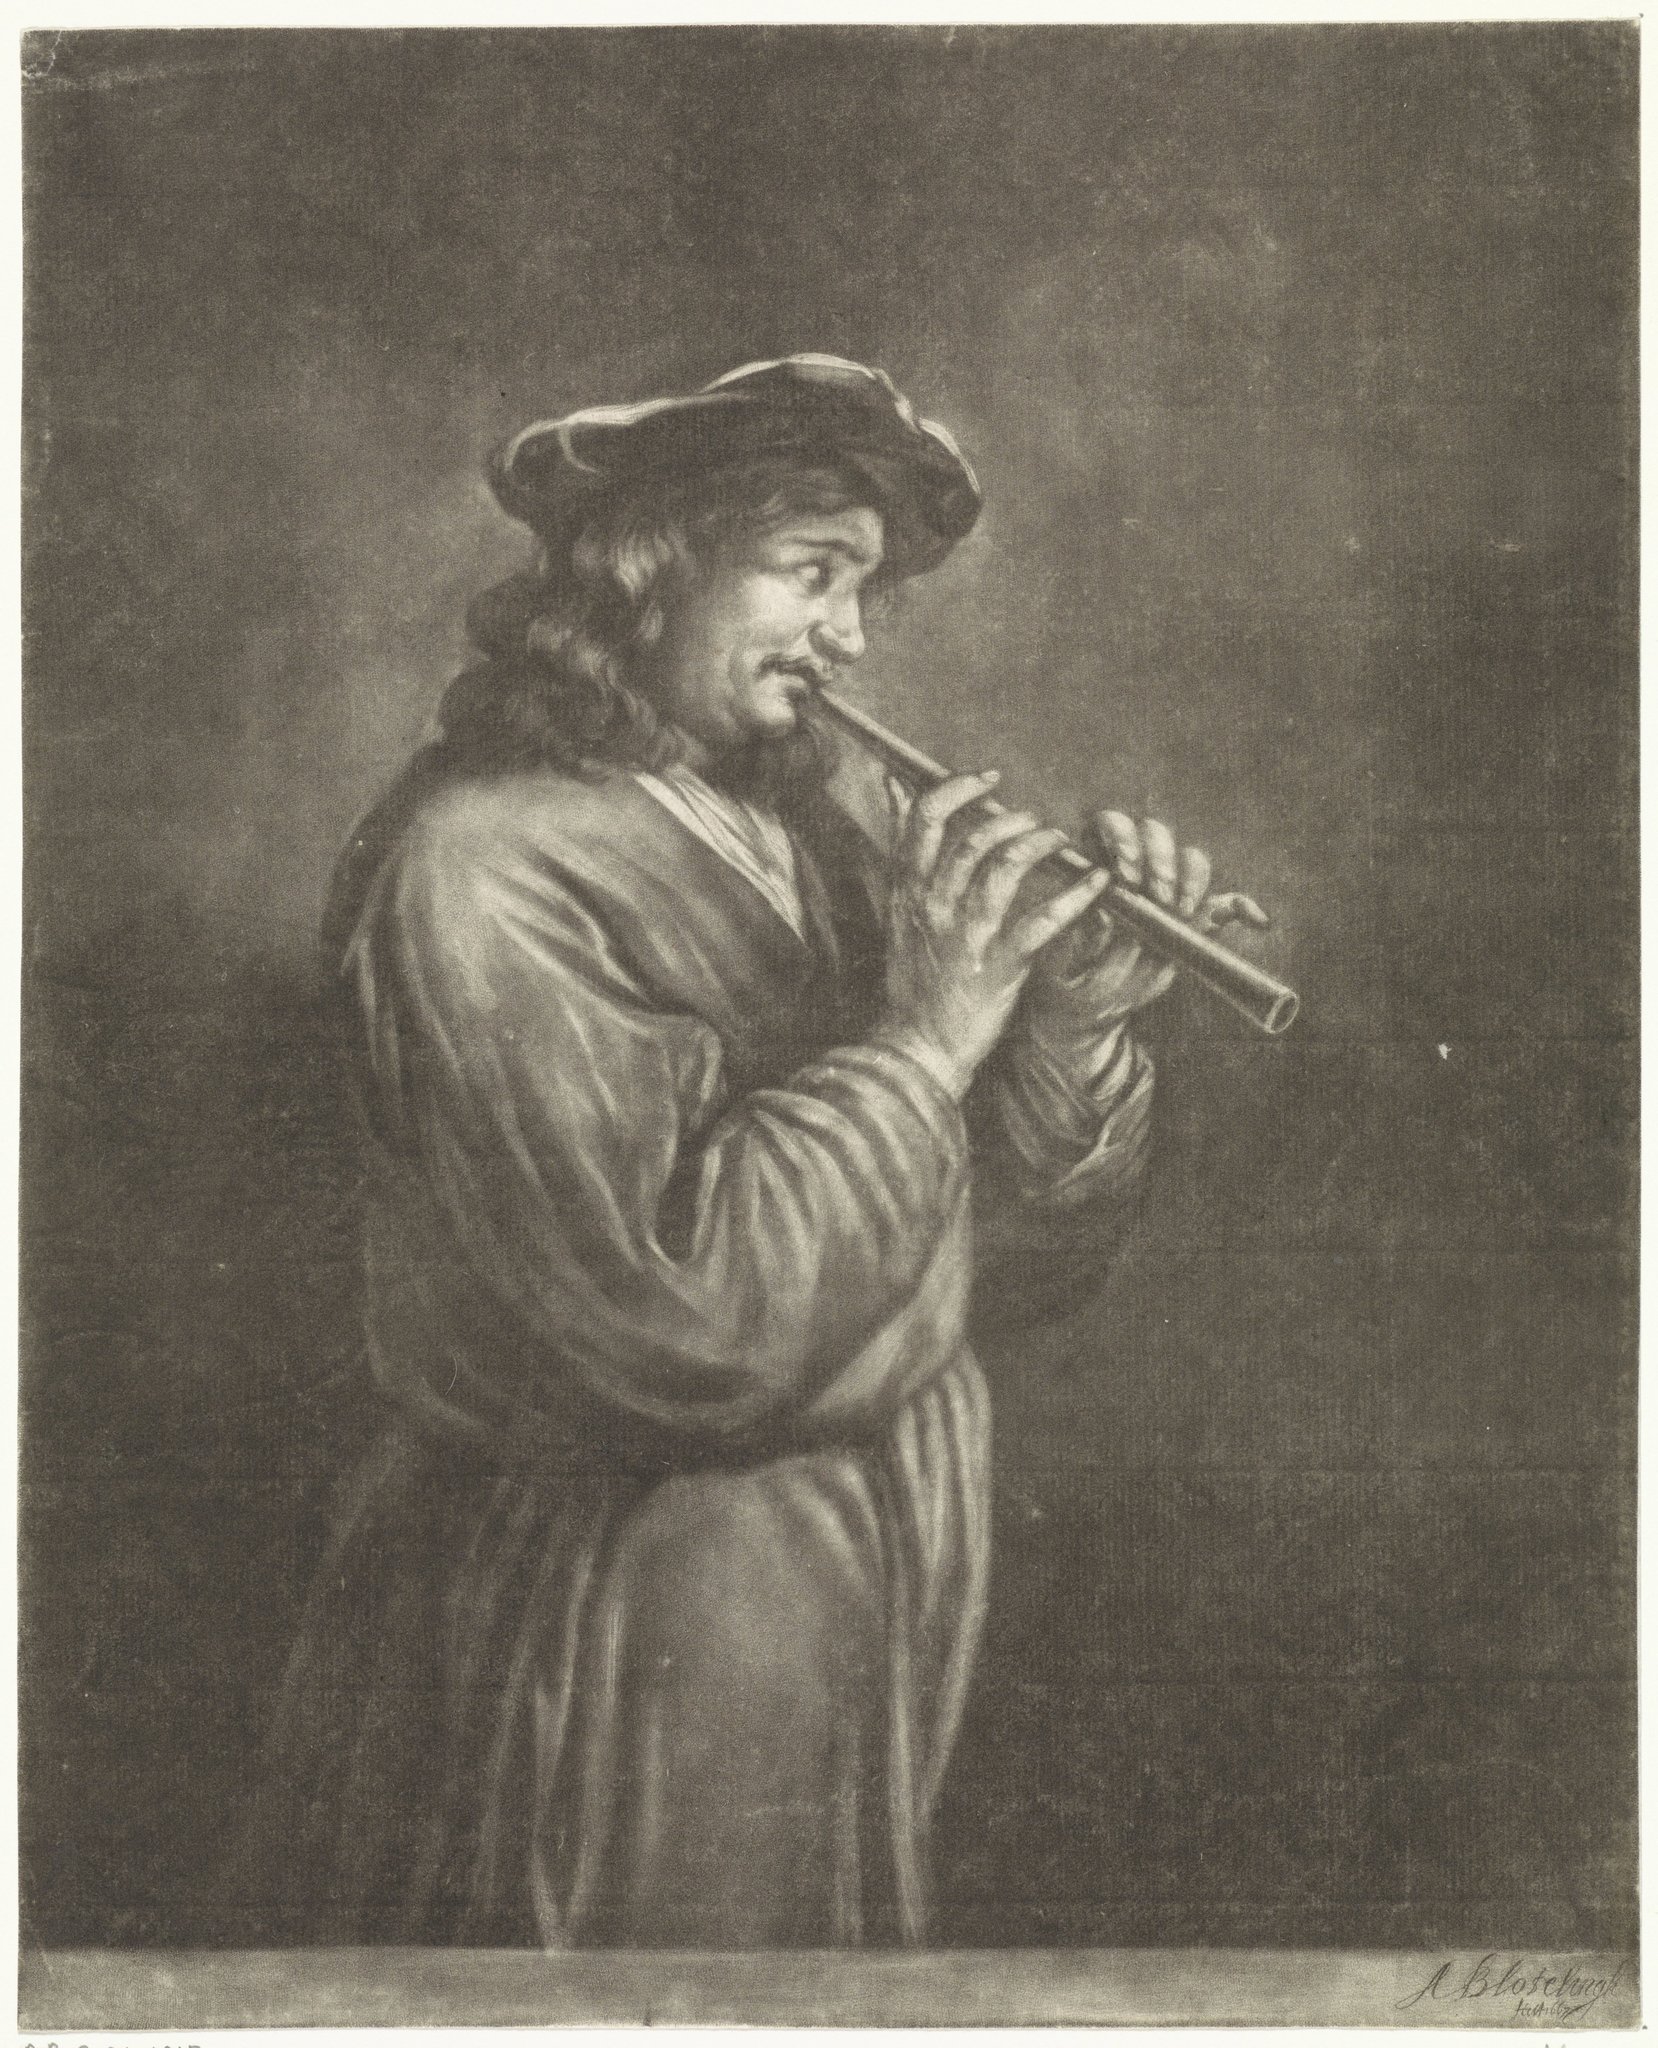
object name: print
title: De fluitspeler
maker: abraham bloteling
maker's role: draughtsman, print maker, publisher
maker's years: 1640-1690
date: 1667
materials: paper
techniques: mezzotint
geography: amsterdam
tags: one person playing wind instrument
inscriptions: collector's mark: Lugt 240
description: Een man, in profiel, bespeelt een fluit.